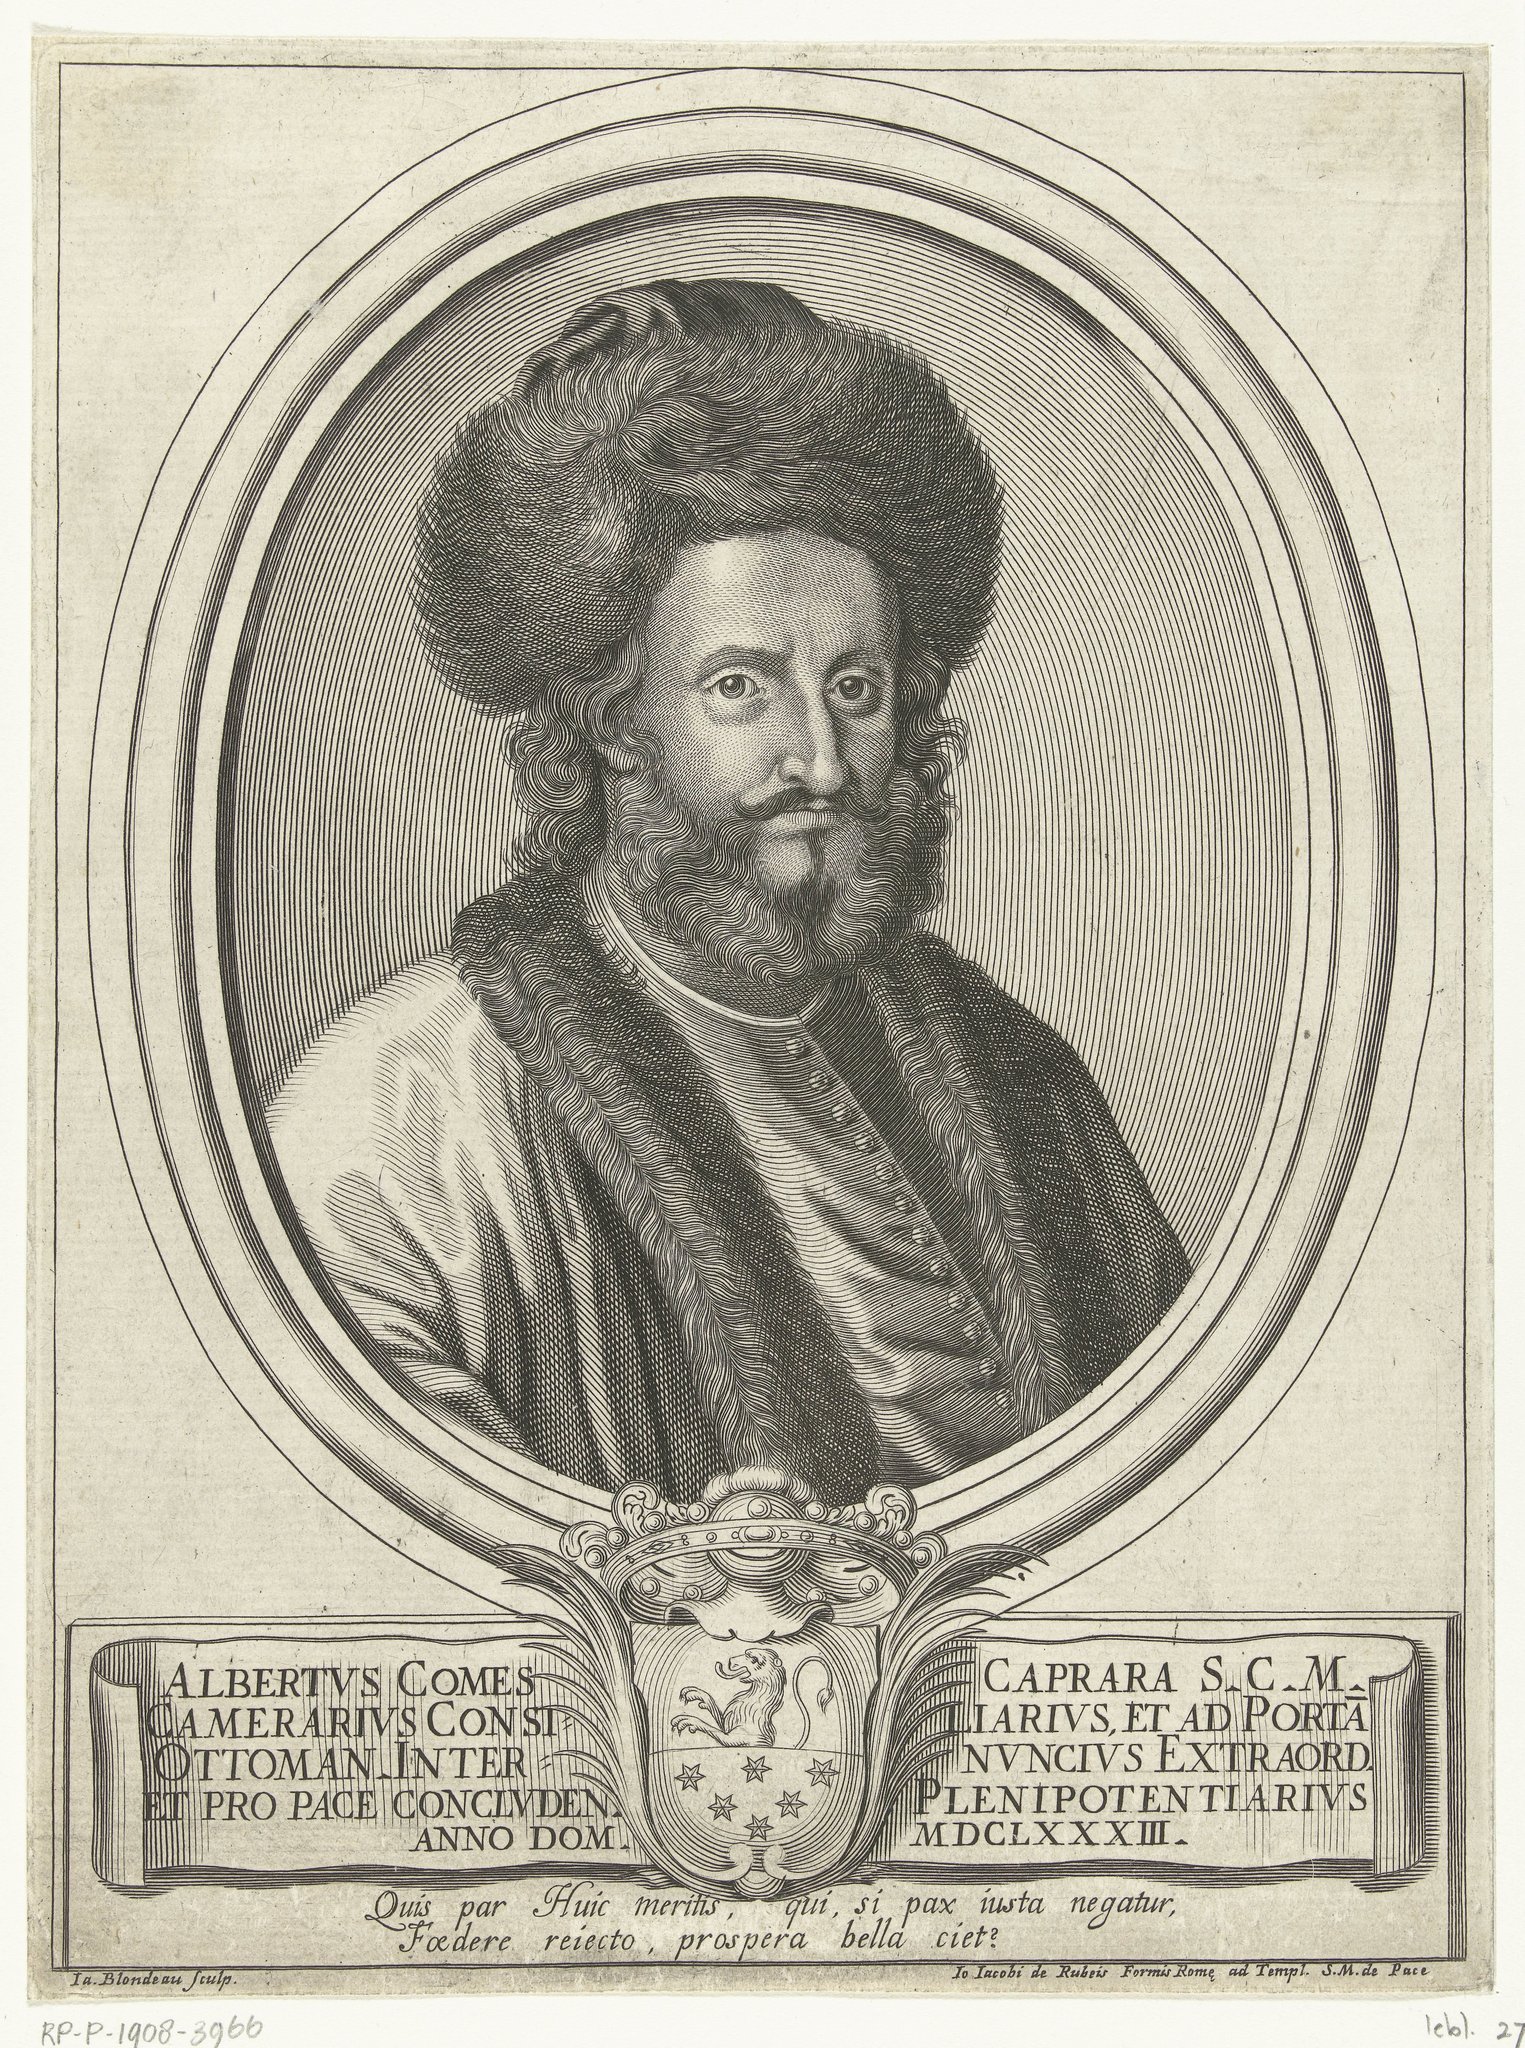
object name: print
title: Albertvs comes Caprara (...) anno dom. MDCLXXXIII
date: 1665-1698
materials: paper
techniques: engraving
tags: alberto caprara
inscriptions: collector's mark: Lugt 2228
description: Portret van Ottomaanse graaf Alberto Caprara, buste met bontmuts in ovale omlijsting, onder het portret zijn wapenschild en een Latijnse versregel.